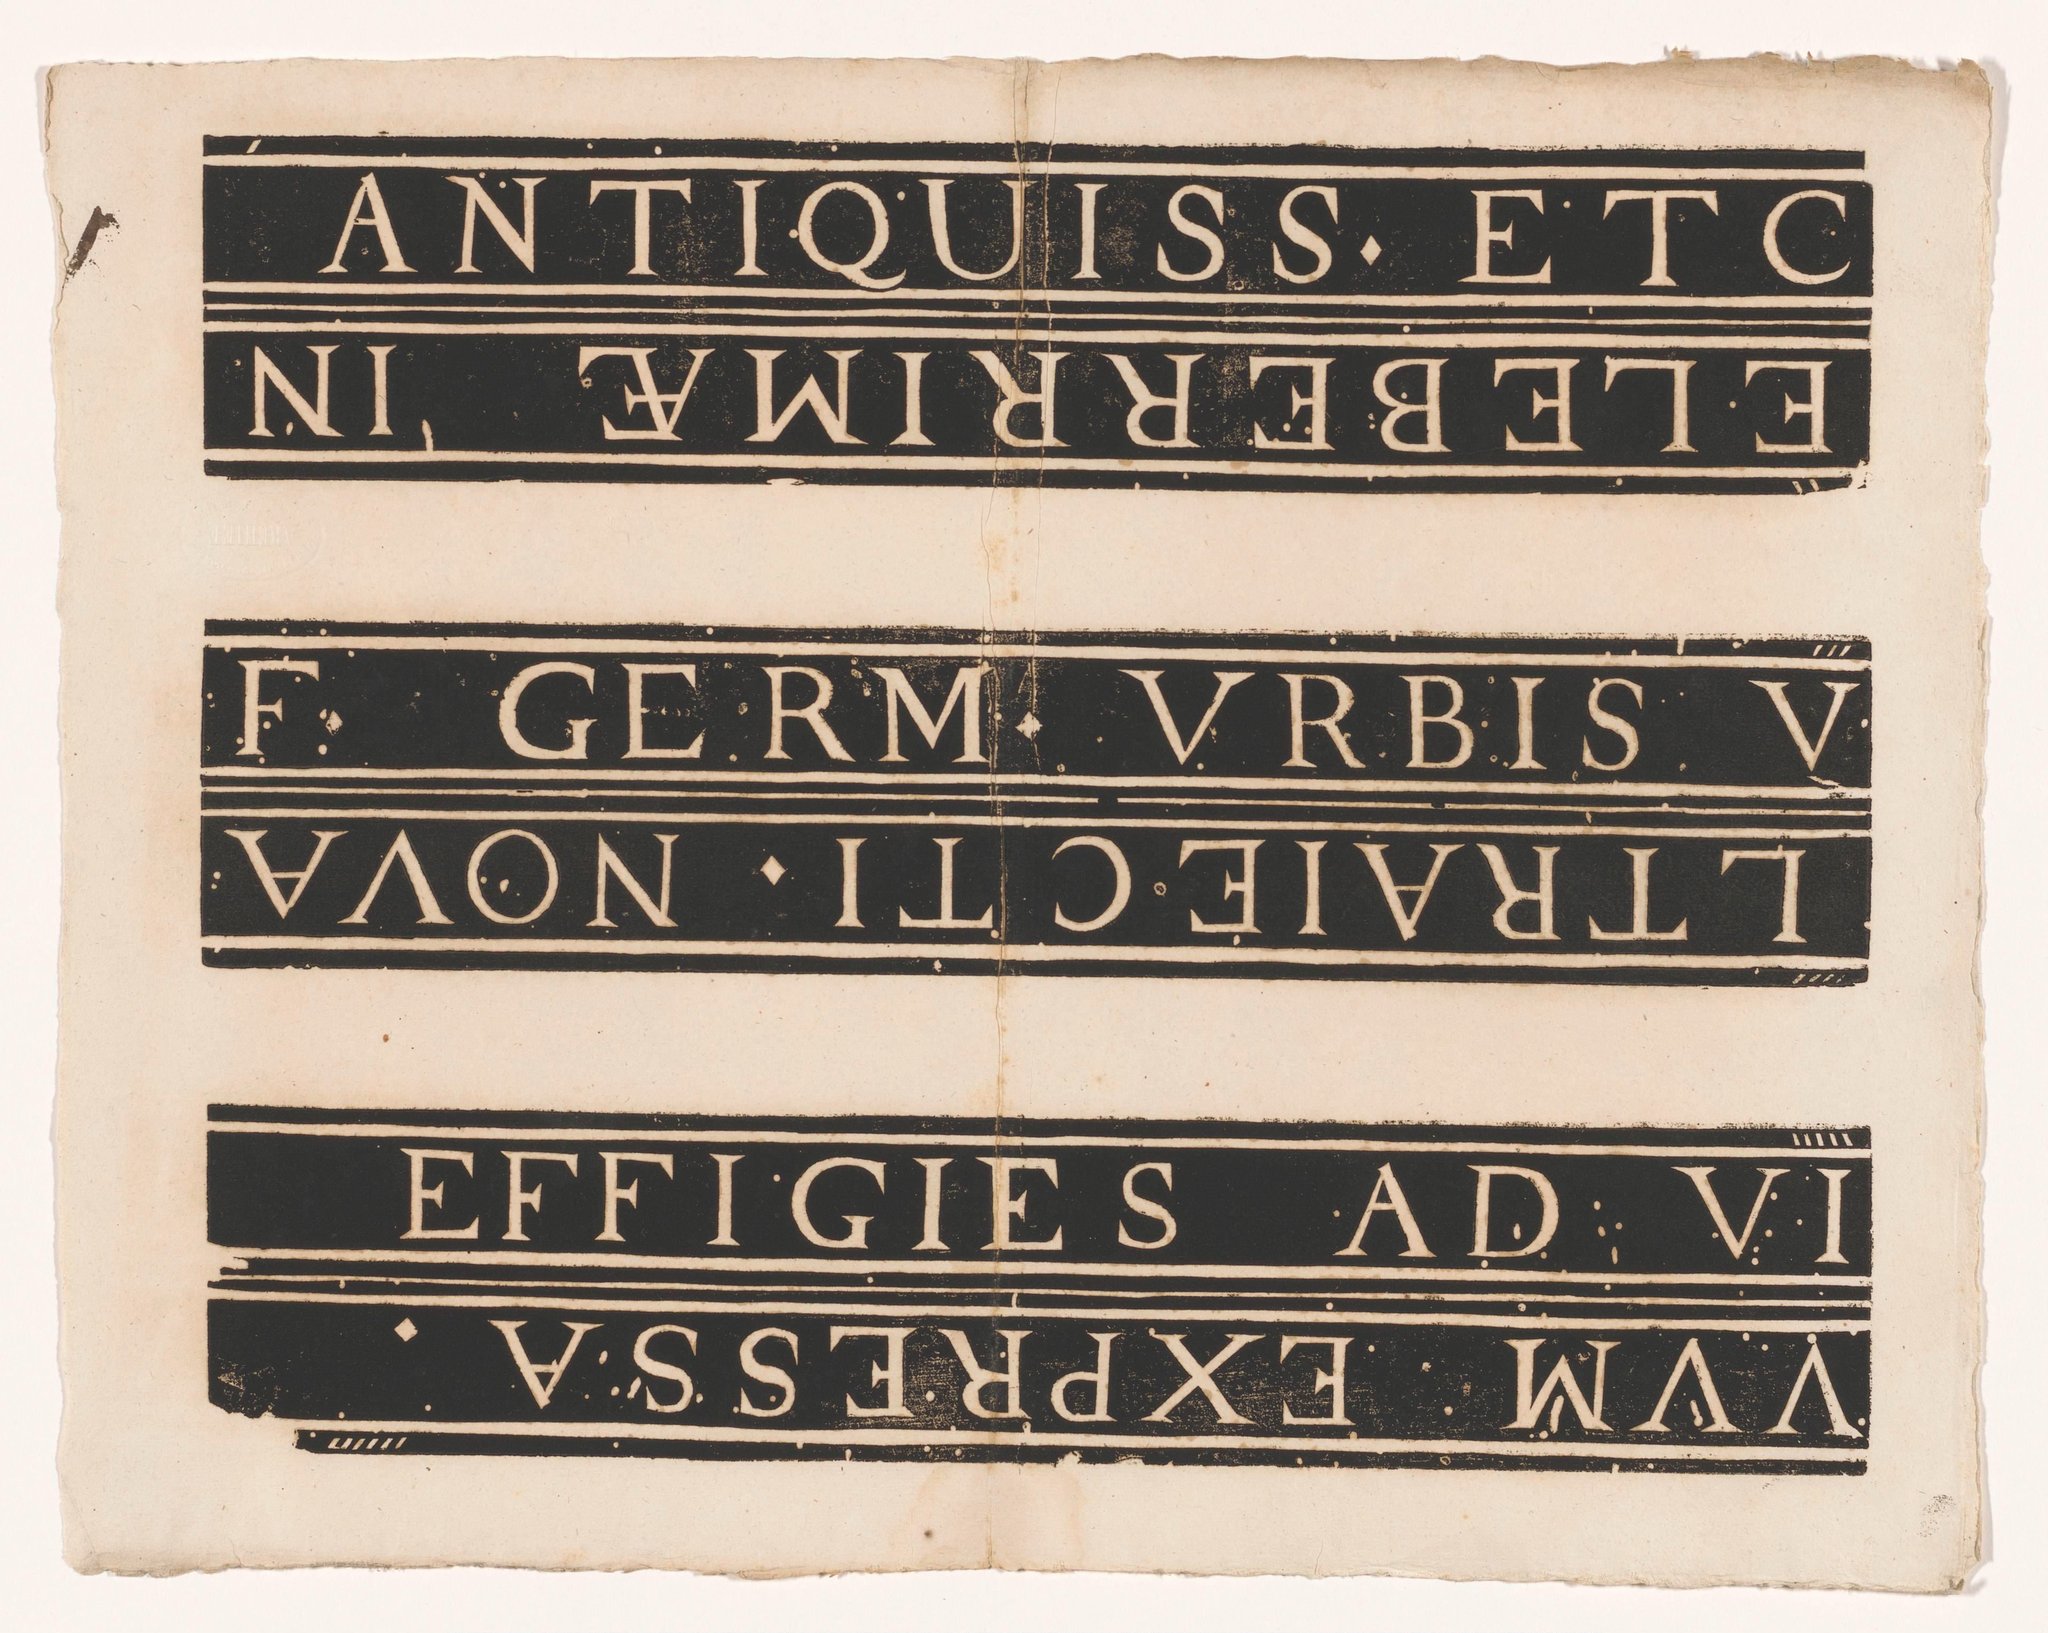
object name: print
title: Antiquiss. et celeberrimae Inf. Germ. urbis Ultraiecti. nova effigies ad vivum expressa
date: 1677-1679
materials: paper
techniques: woodcut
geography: amsterdam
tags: utrecht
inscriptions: check stamp: ‘Archief Ministerie van Oorlog Afdeeling Genie’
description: Titelstrook die hoort bij een beschrijving en een stadsgezicht van de stad Utrecht (zie gerelateerde objecten).